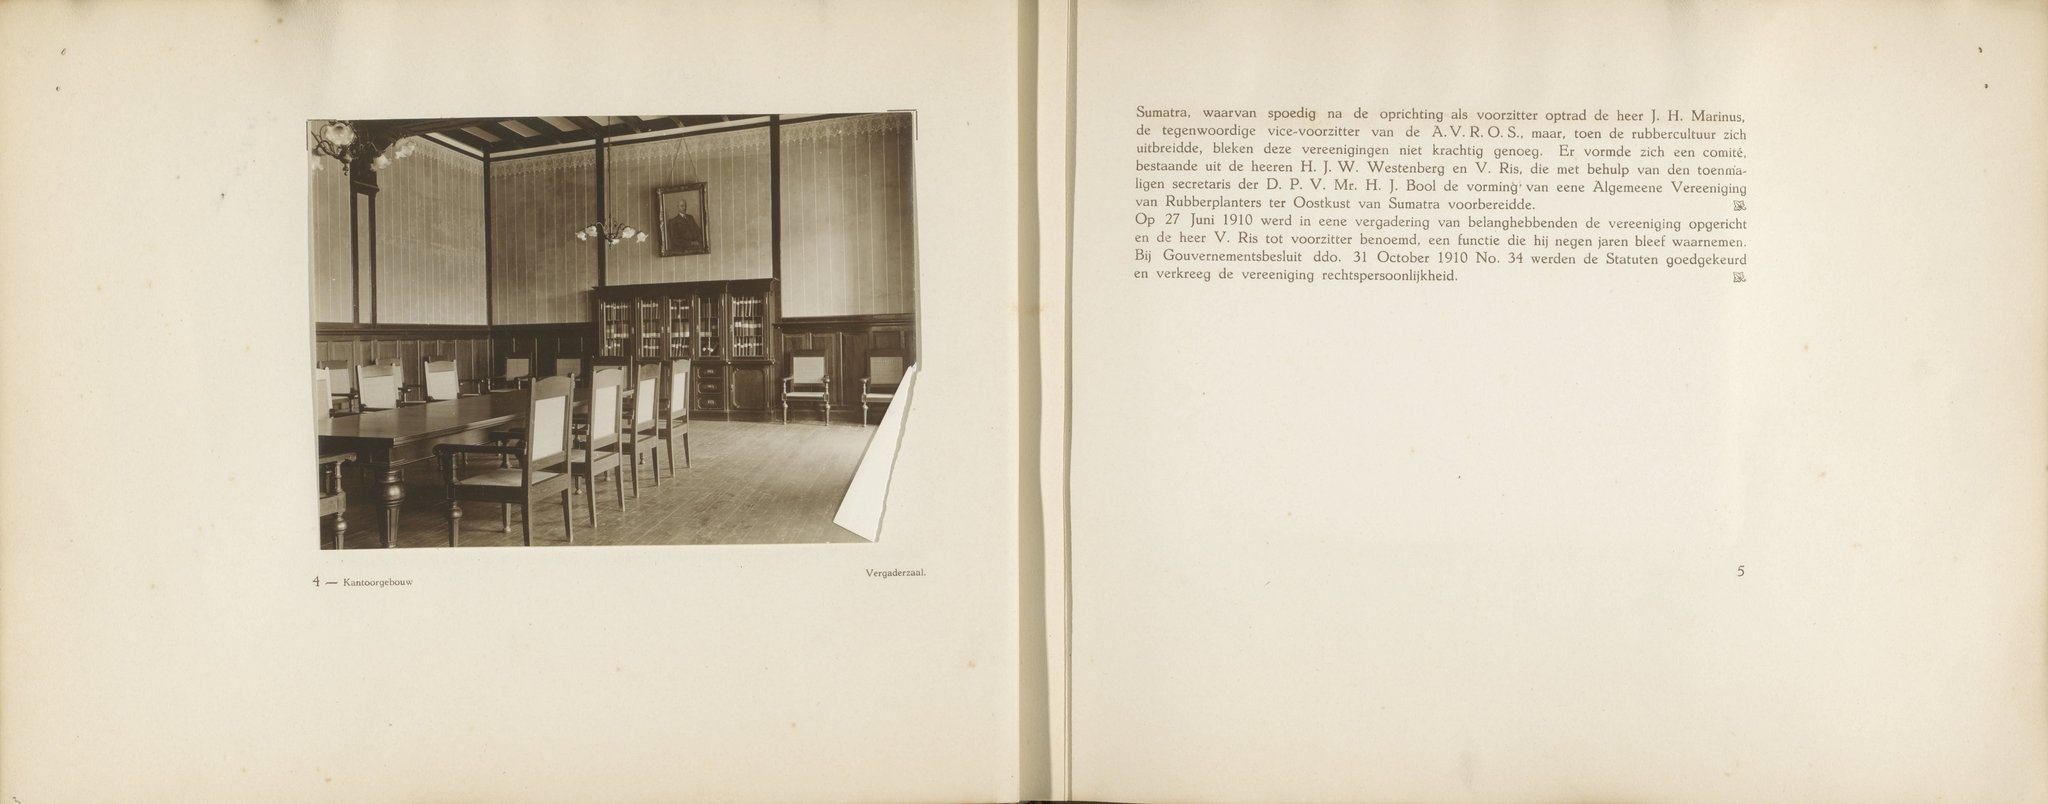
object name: album leaf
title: Pagina 4 en 5 van fotoboek van de Algemeene Vereeniging van Rubberplanters ter Oostkust van Sumatra (A.V.R.O.S.)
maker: j.w. meyster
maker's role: fotograaf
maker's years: 1887-1945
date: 1924-1925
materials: paper, photographic support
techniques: printing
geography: medan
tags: (non-fruit) products of plants or trees: rubber, civic architecture; edifices; dwellings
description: Twee boekpagina's met links een foto van een vergaderzaal van de A.V.R.O.S. te Medan en rechts informatie over het ontstaan van deze vereniging. Onderdeel van een fotoboek van de Algemeene Vereeniging van Rubberplanters ter Oostkust van Sumatra (A.V.R.O.S.).